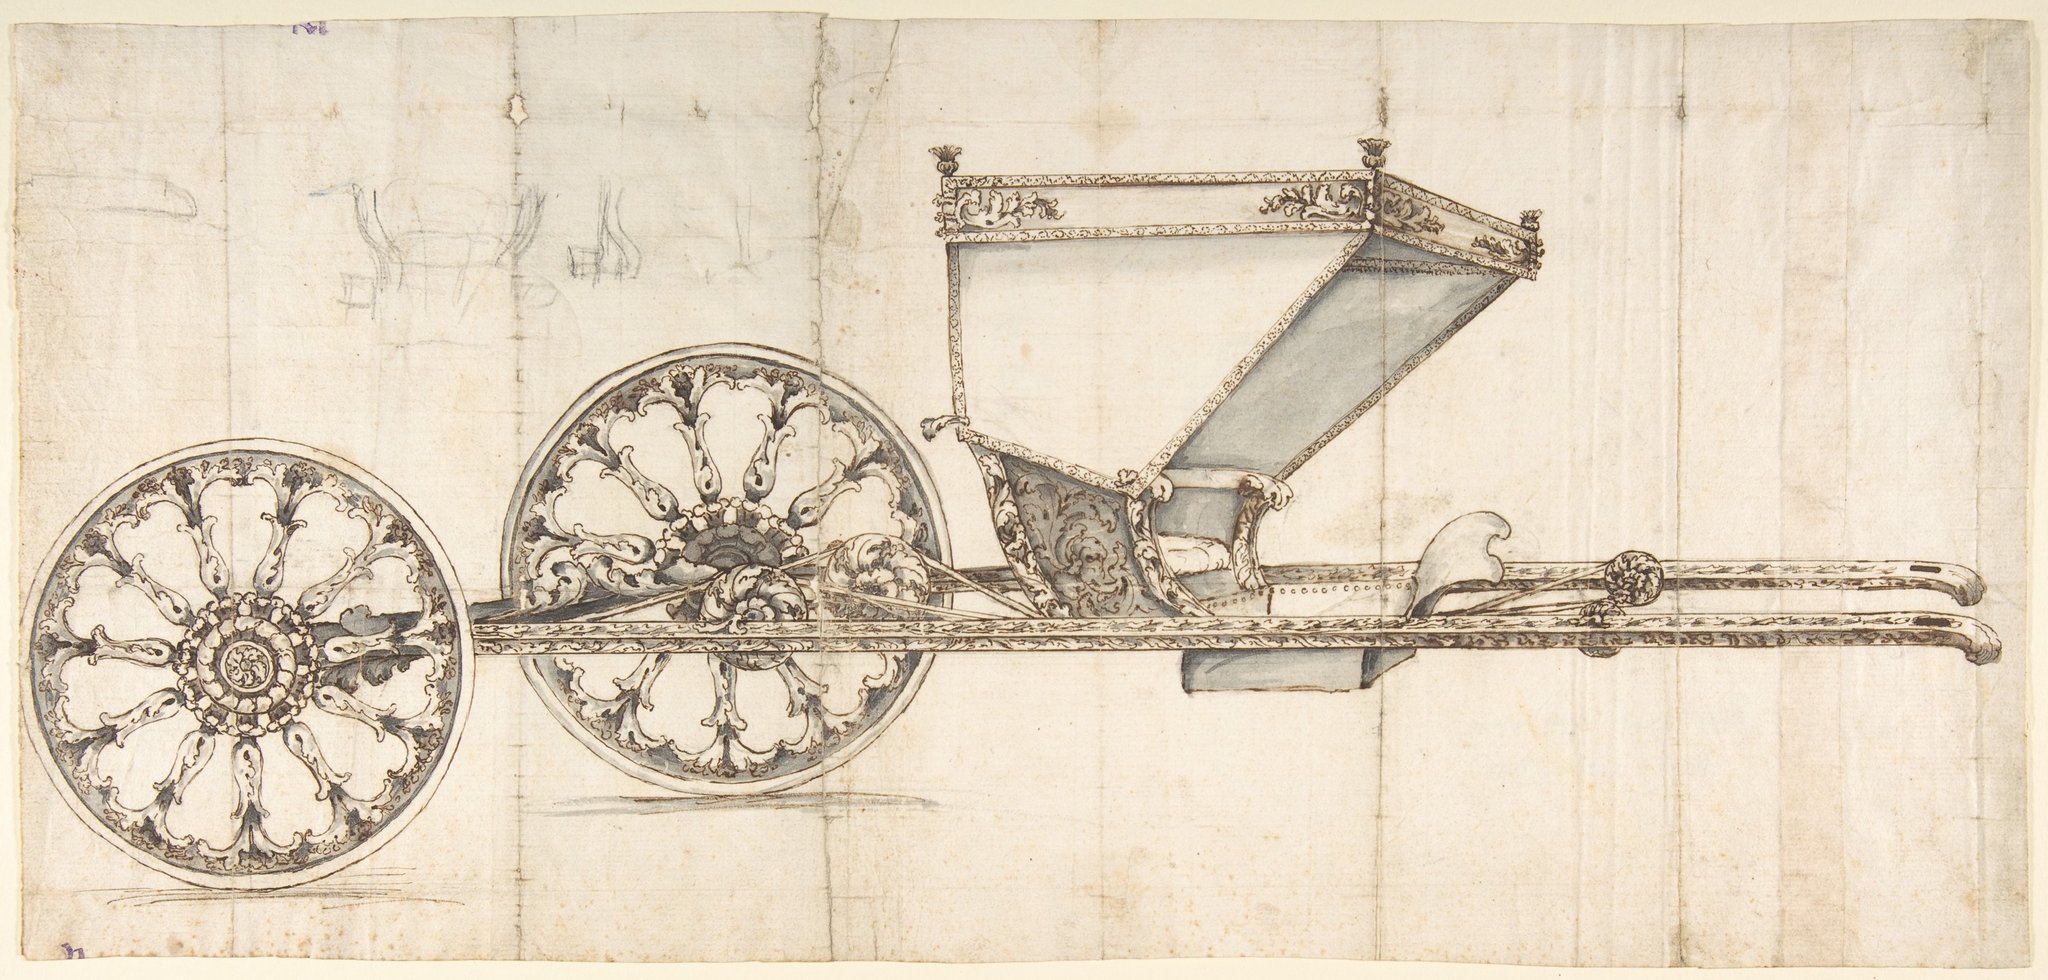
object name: drawing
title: Design for a Carriage (Chaise Italienne?)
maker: anonymous, italian, 18th century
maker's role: artist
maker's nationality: italian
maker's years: 1700-1800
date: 1701-1800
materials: chalk, ink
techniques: brush, pen, wash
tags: carriages